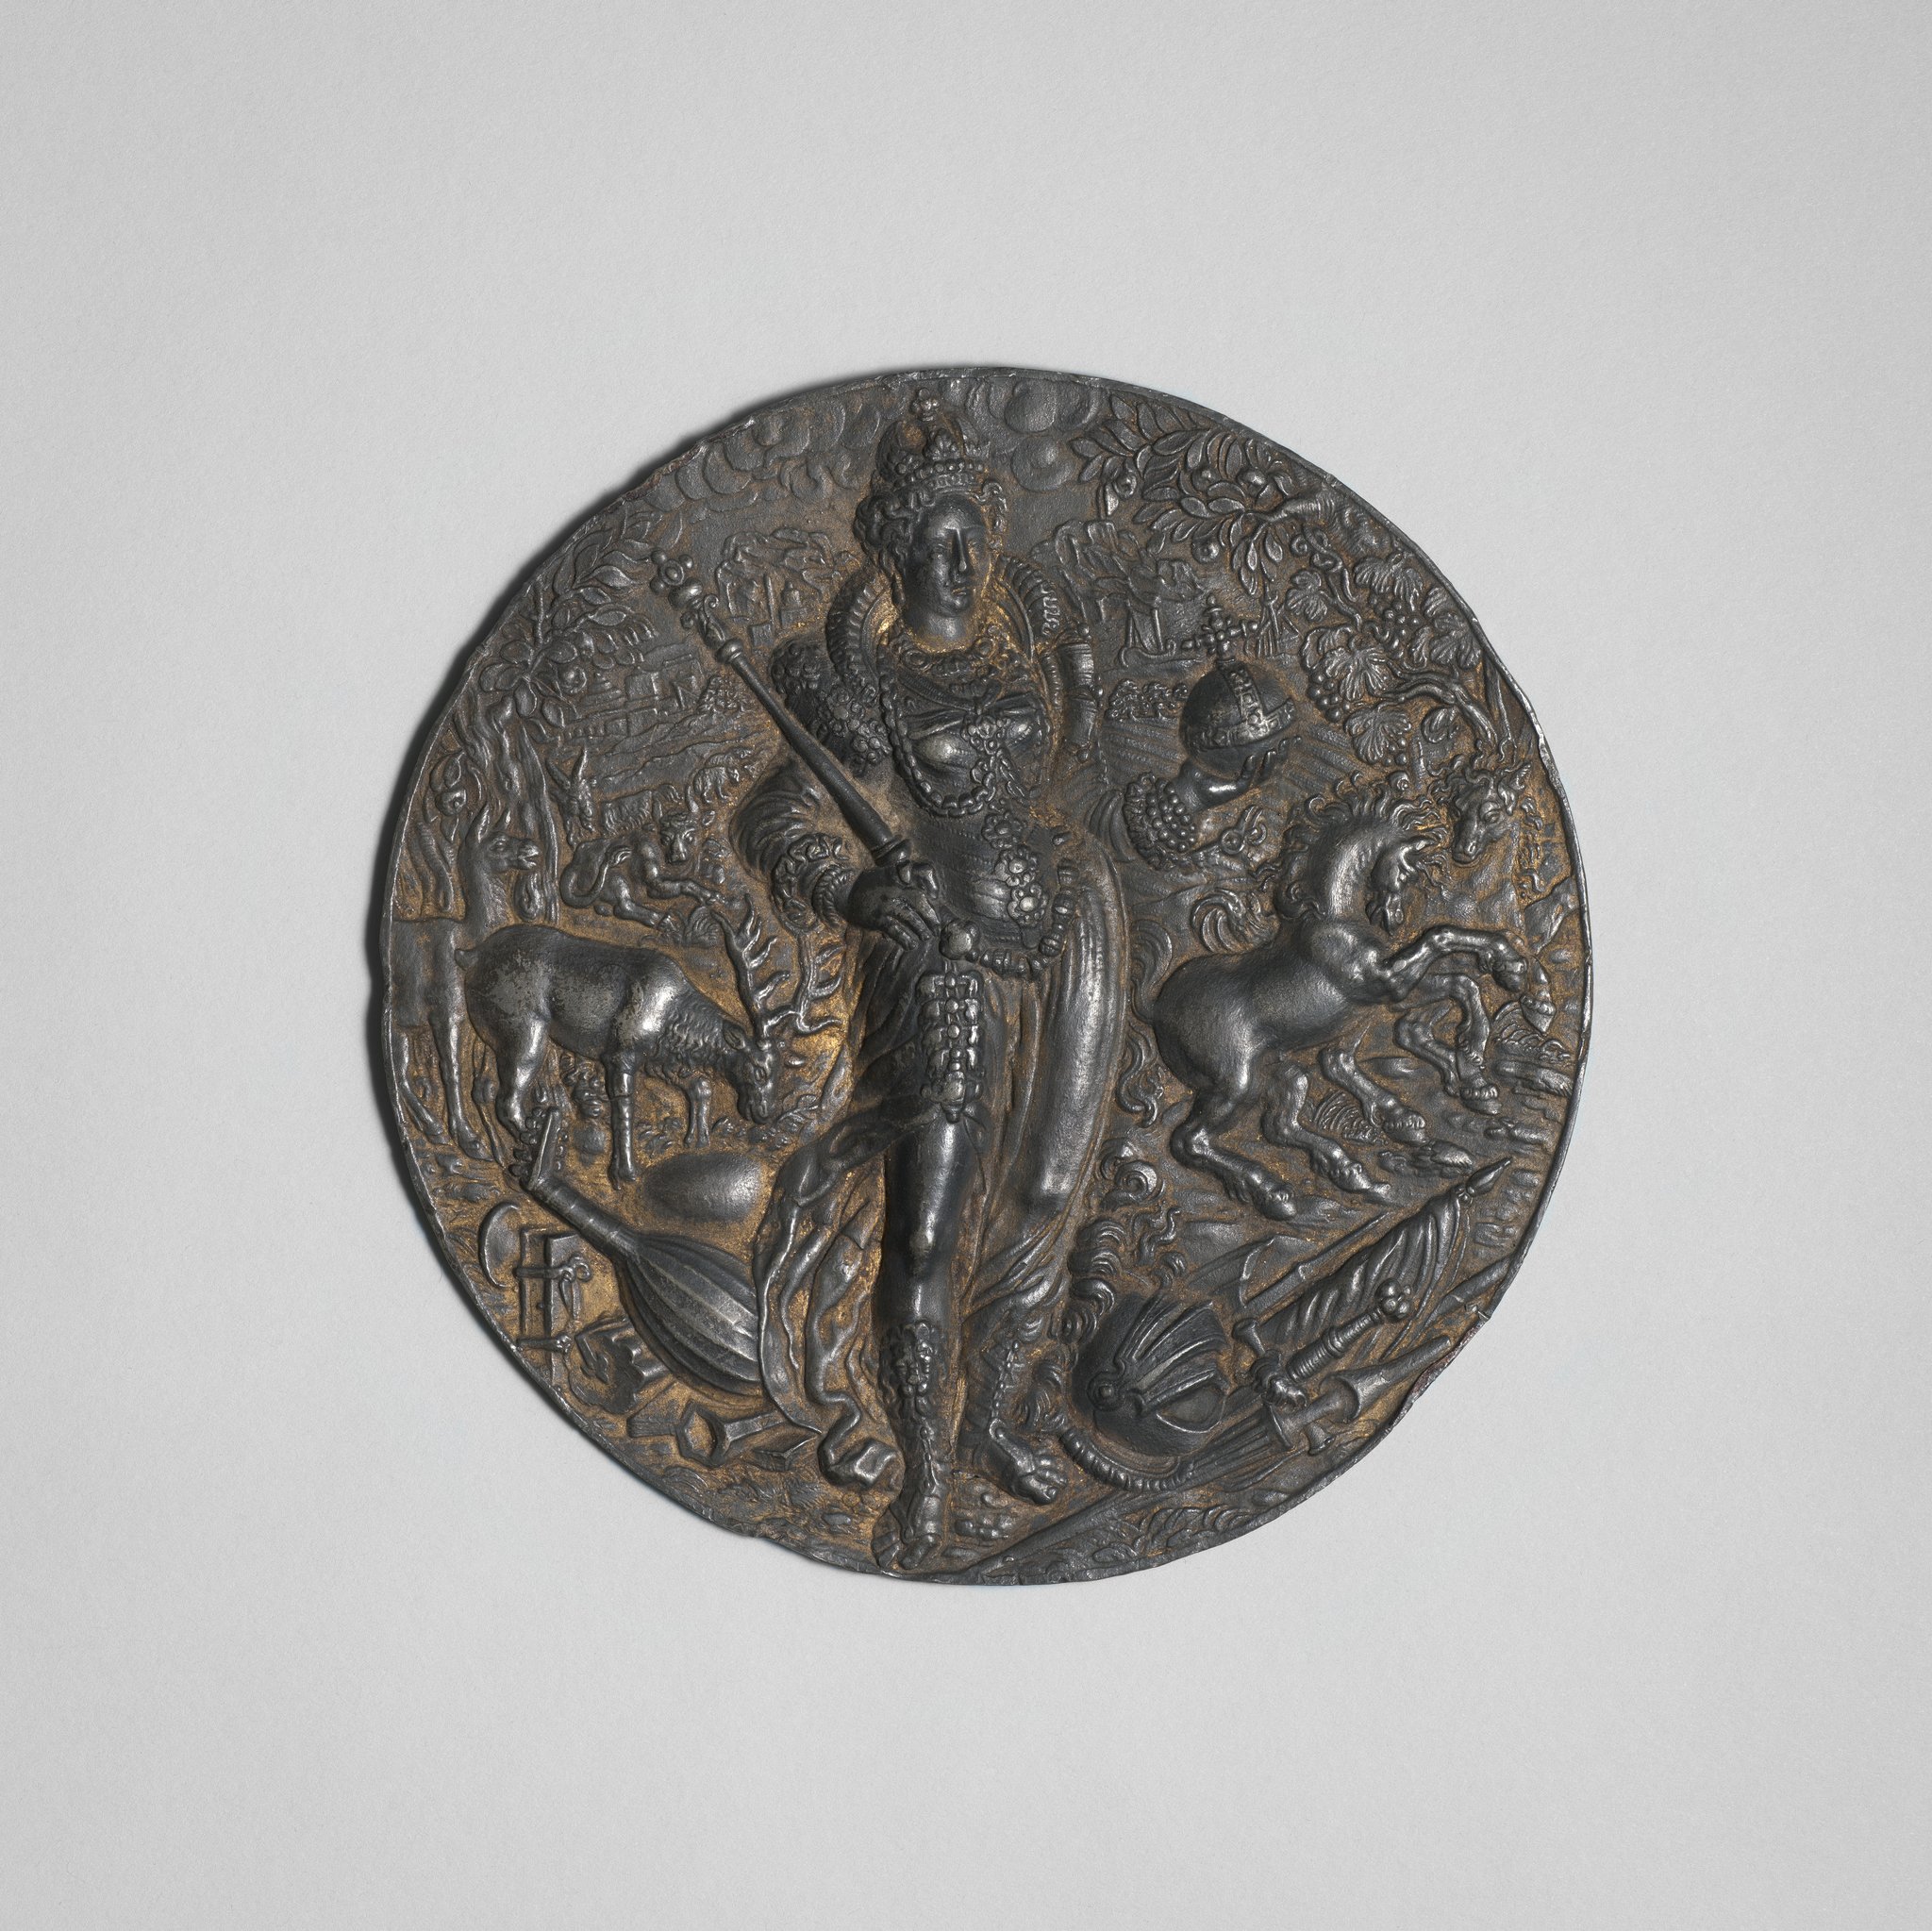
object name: plaquette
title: Personification of Europe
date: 1580-1590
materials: lead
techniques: gilding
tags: women,deer,horses